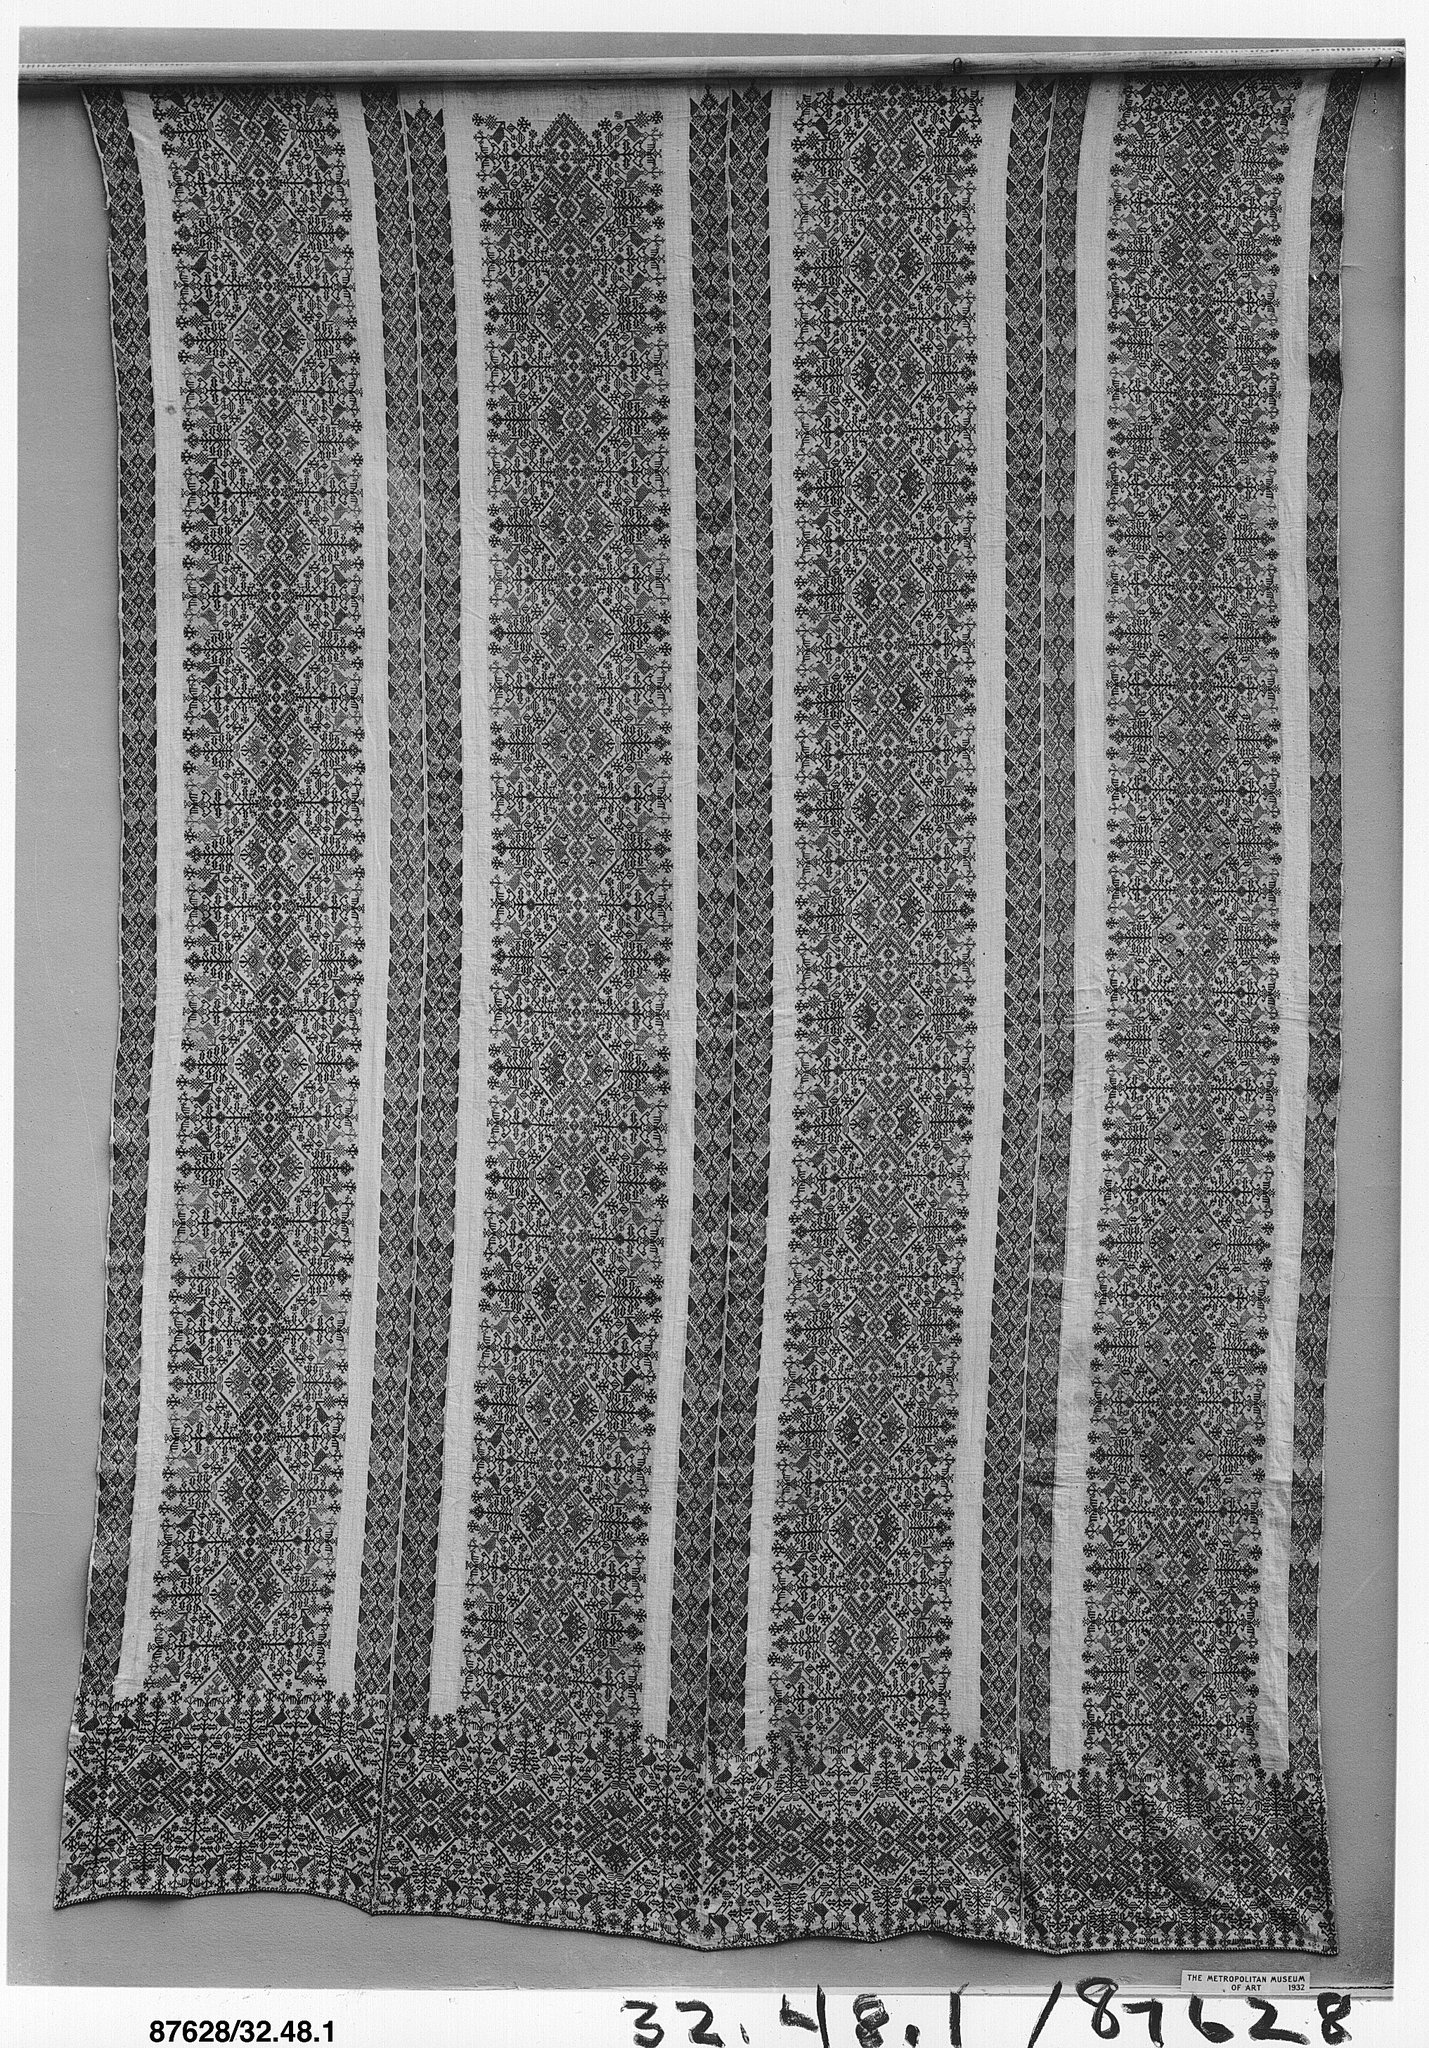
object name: bed curtain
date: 1701-1800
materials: linen, silk